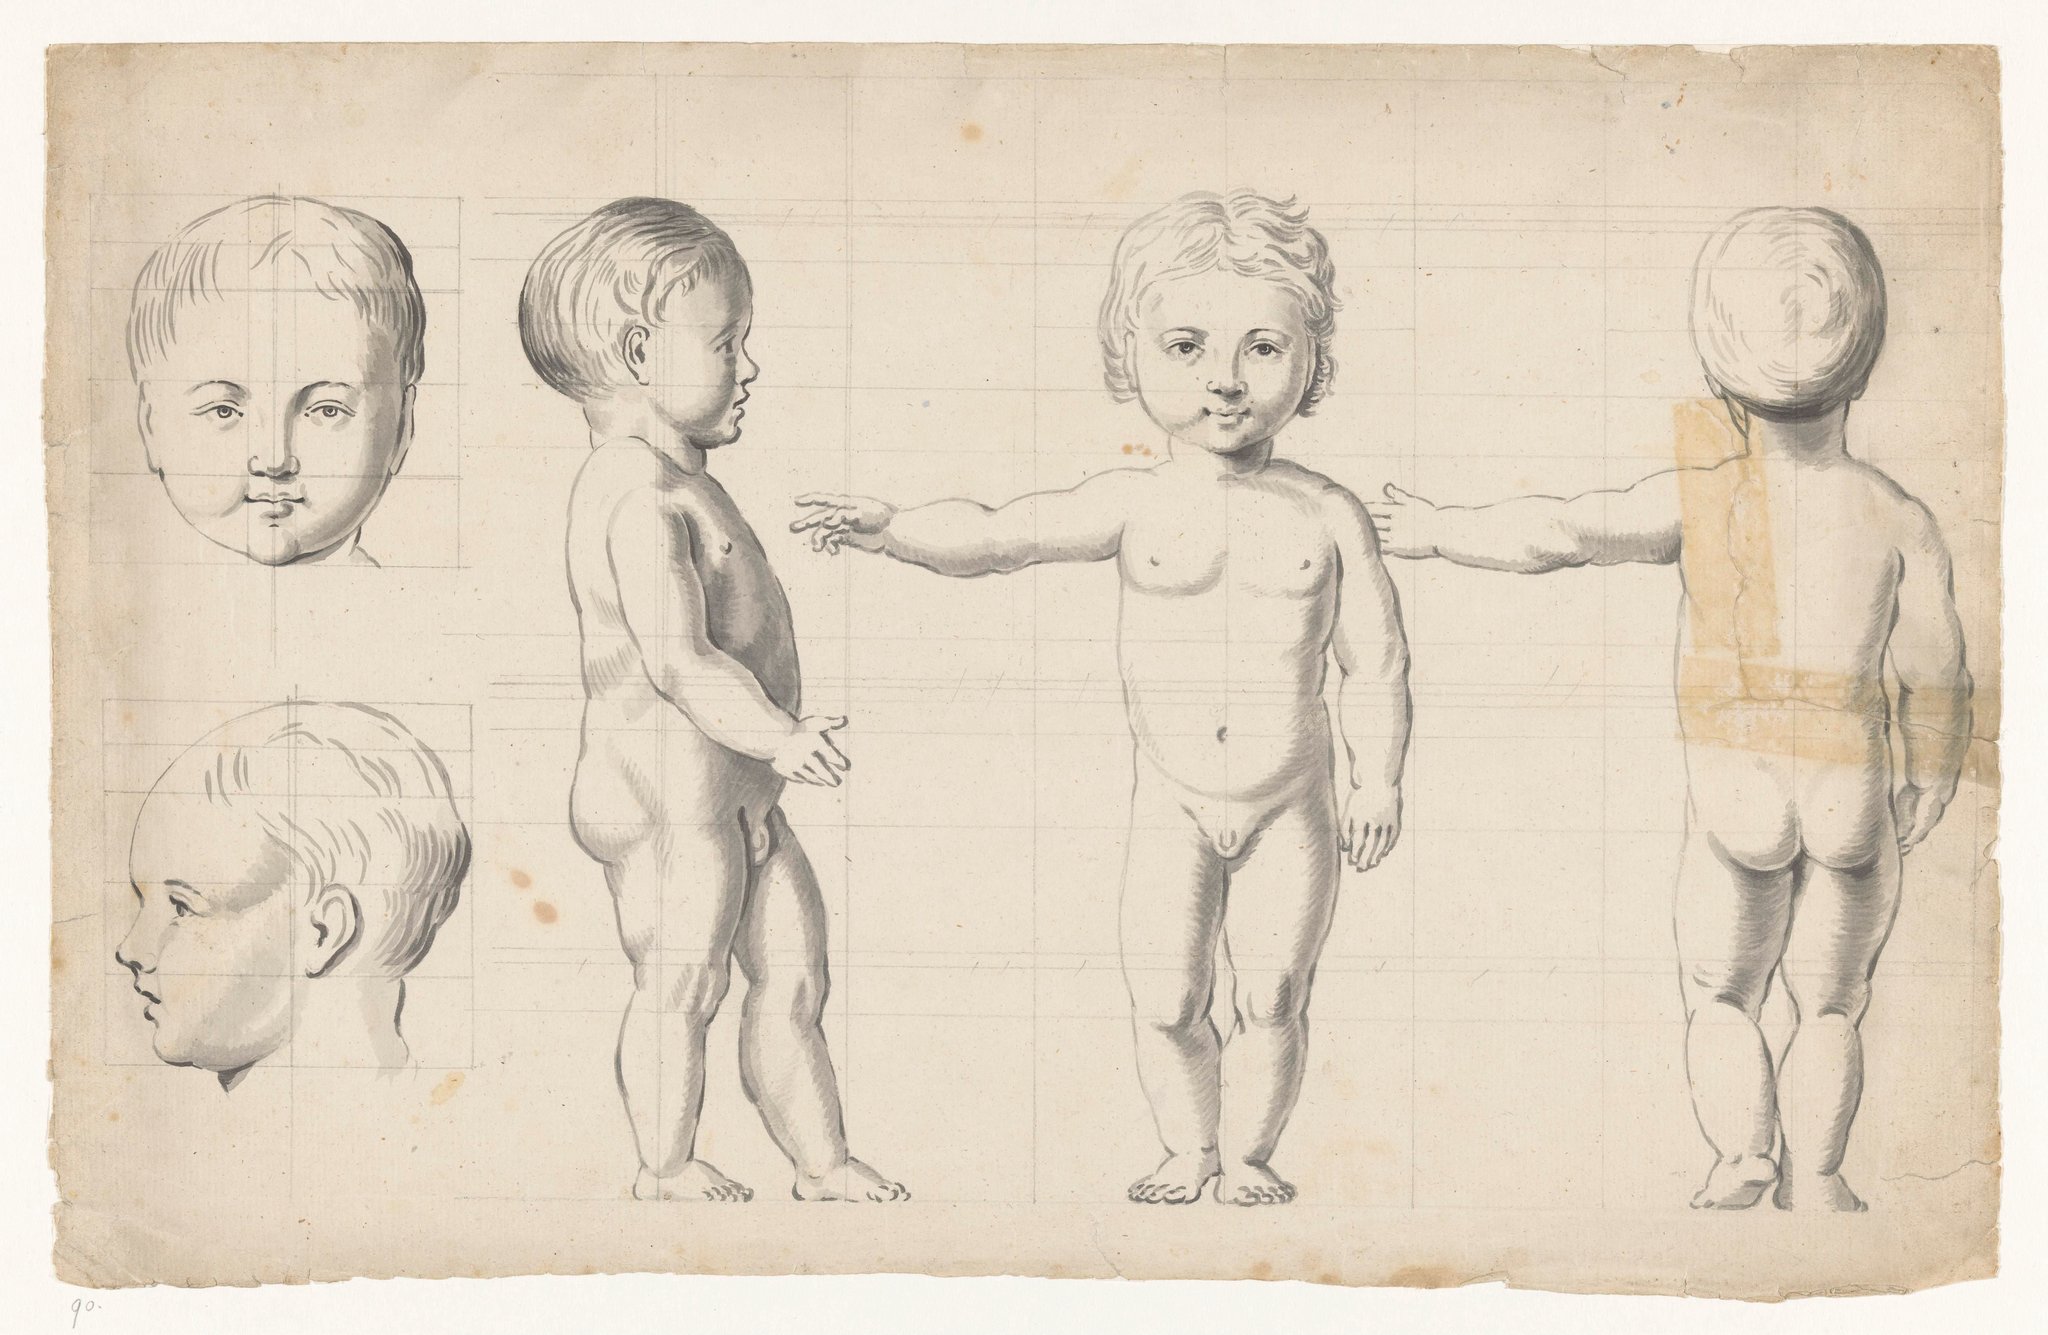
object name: drawing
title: Naaktstudies van een jongetje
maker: jan brandes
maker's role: draughtsman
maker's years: 1743-1808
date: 1787-1808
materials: ink, paper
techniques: brush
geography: skälsebo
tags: standing figure, toddler (male), standing figure (canon, proportions)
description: Schematische academische figuurstudies van een jongetje, gezien van verschillende kanten. Gekopieerd uit een voorbeeldboek.